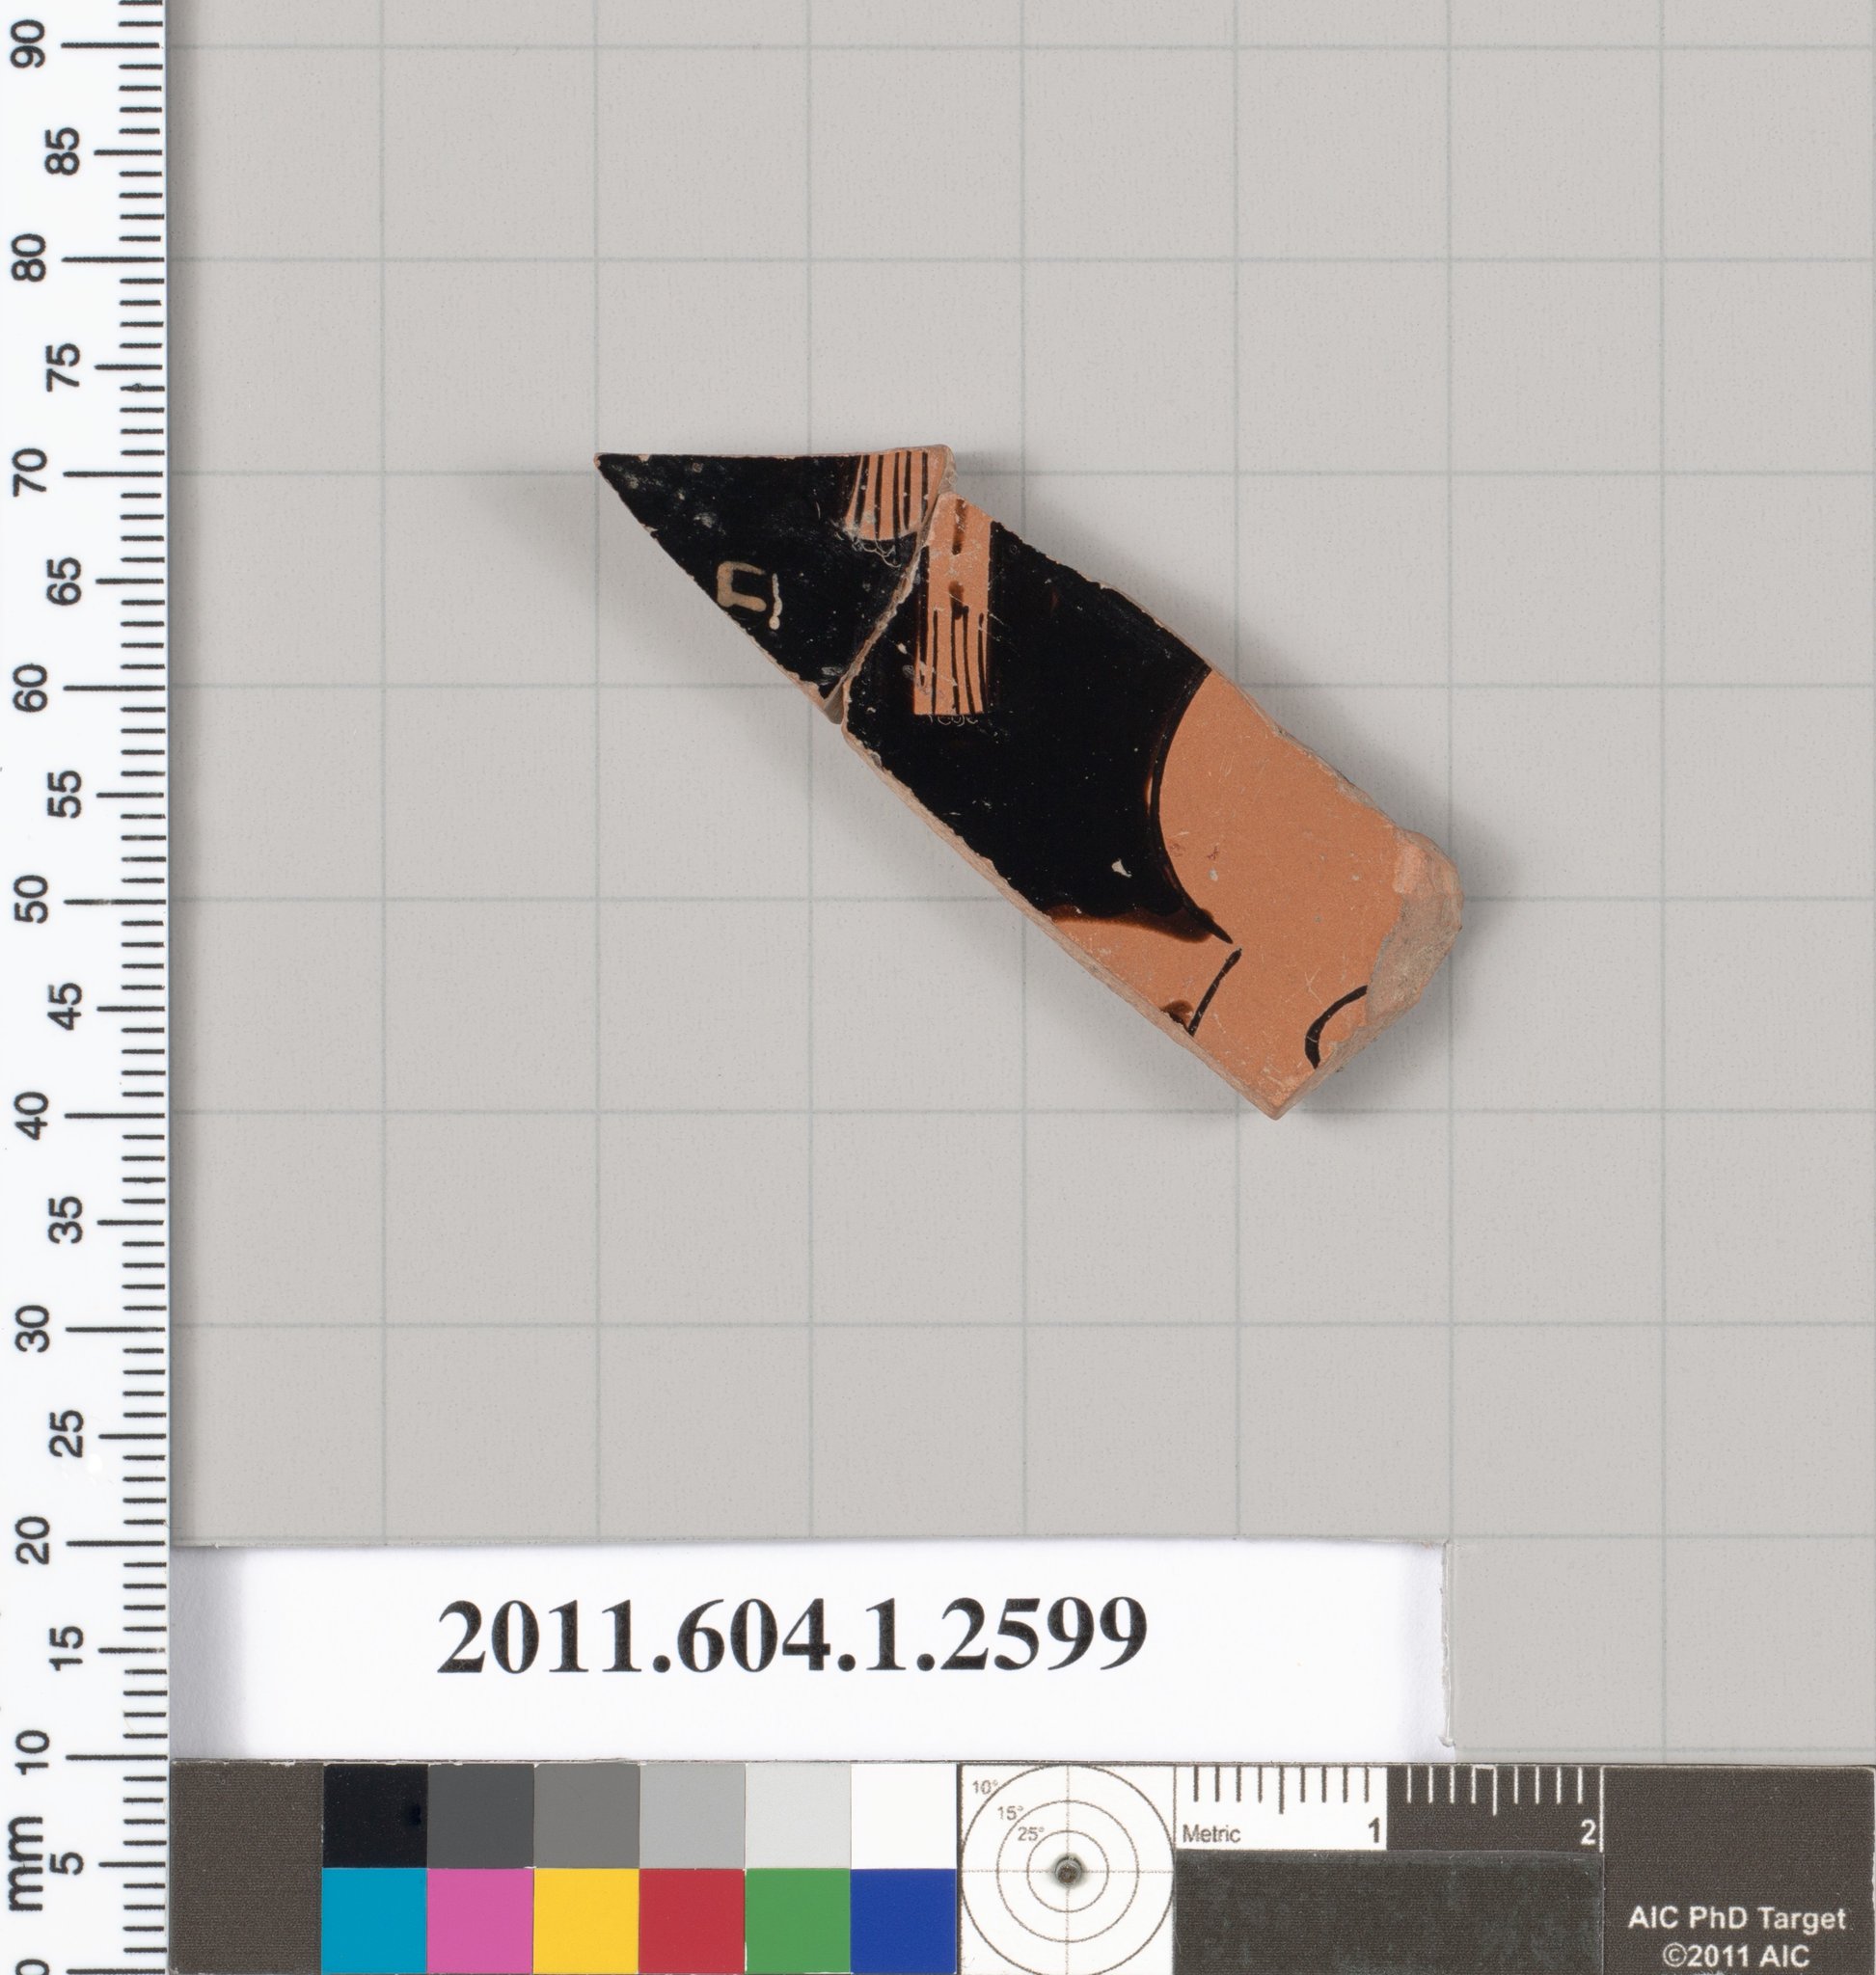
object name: kylix fragment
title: Terracotta fragment of a kylix (drinking cup)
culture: greek, attic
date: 490-480 BCE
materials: terracotta